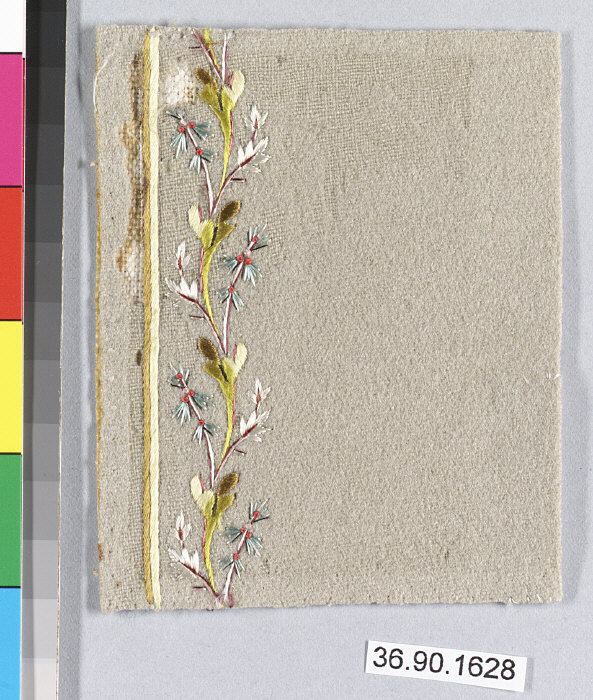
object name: sample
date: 1801-1833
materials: felt, silk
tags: flowers